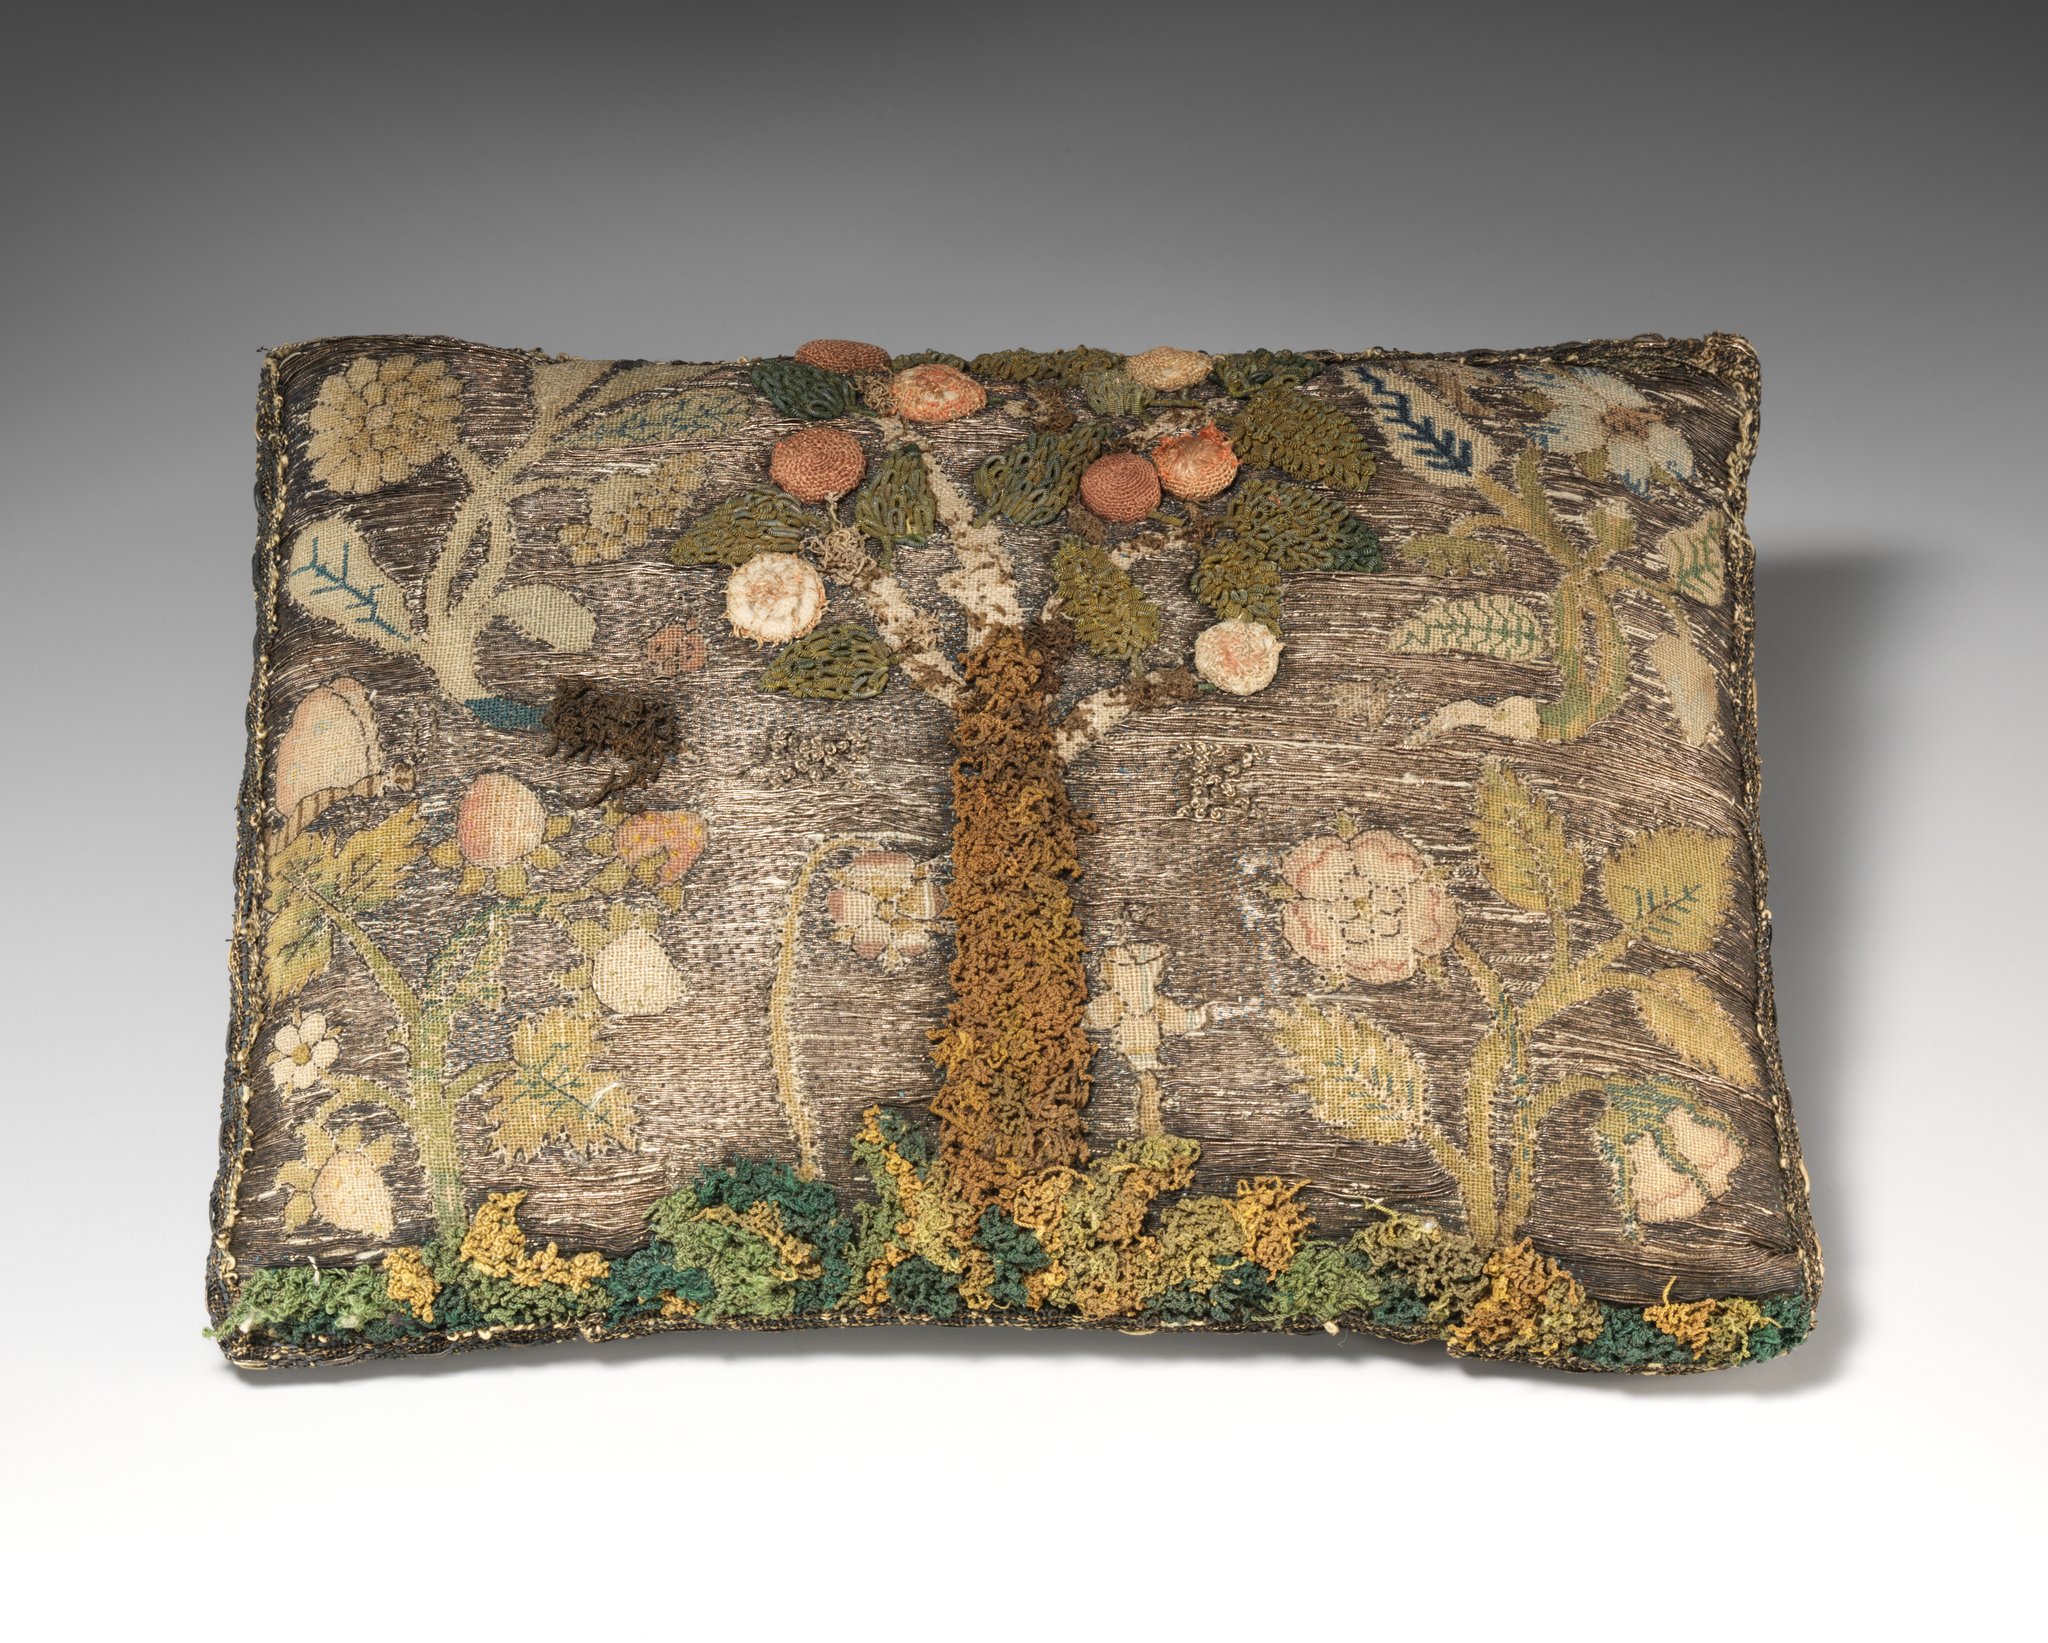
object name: cushion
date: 1601-1650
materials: canvas, metal thread, silk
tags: flowers,trees